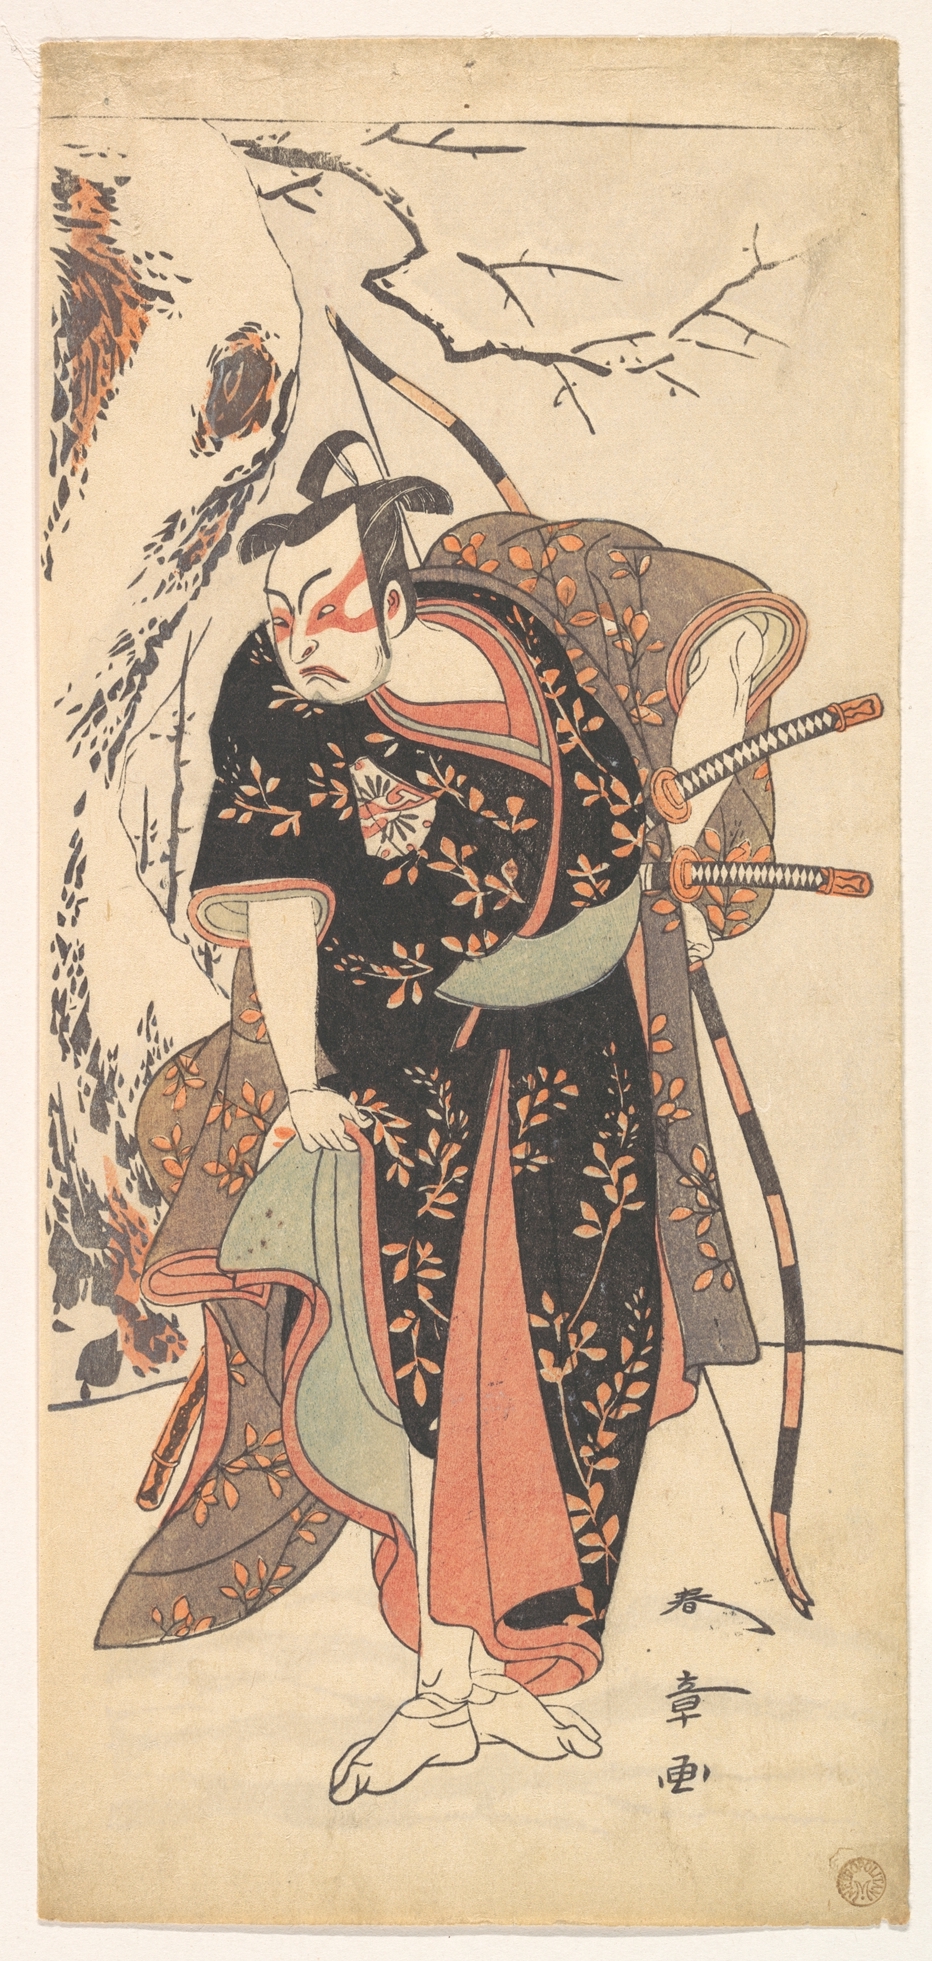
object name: woodblock print nishiki e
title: The Second Nakamura Juzo as a Samurai of High Rank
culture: japanese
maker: katsukawa shunshō 勝川春章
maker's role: artist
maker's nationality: japanese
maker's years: 1726-1792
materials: ink, paper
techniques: nishiki e, woodblock print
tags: bow and arrow,actors